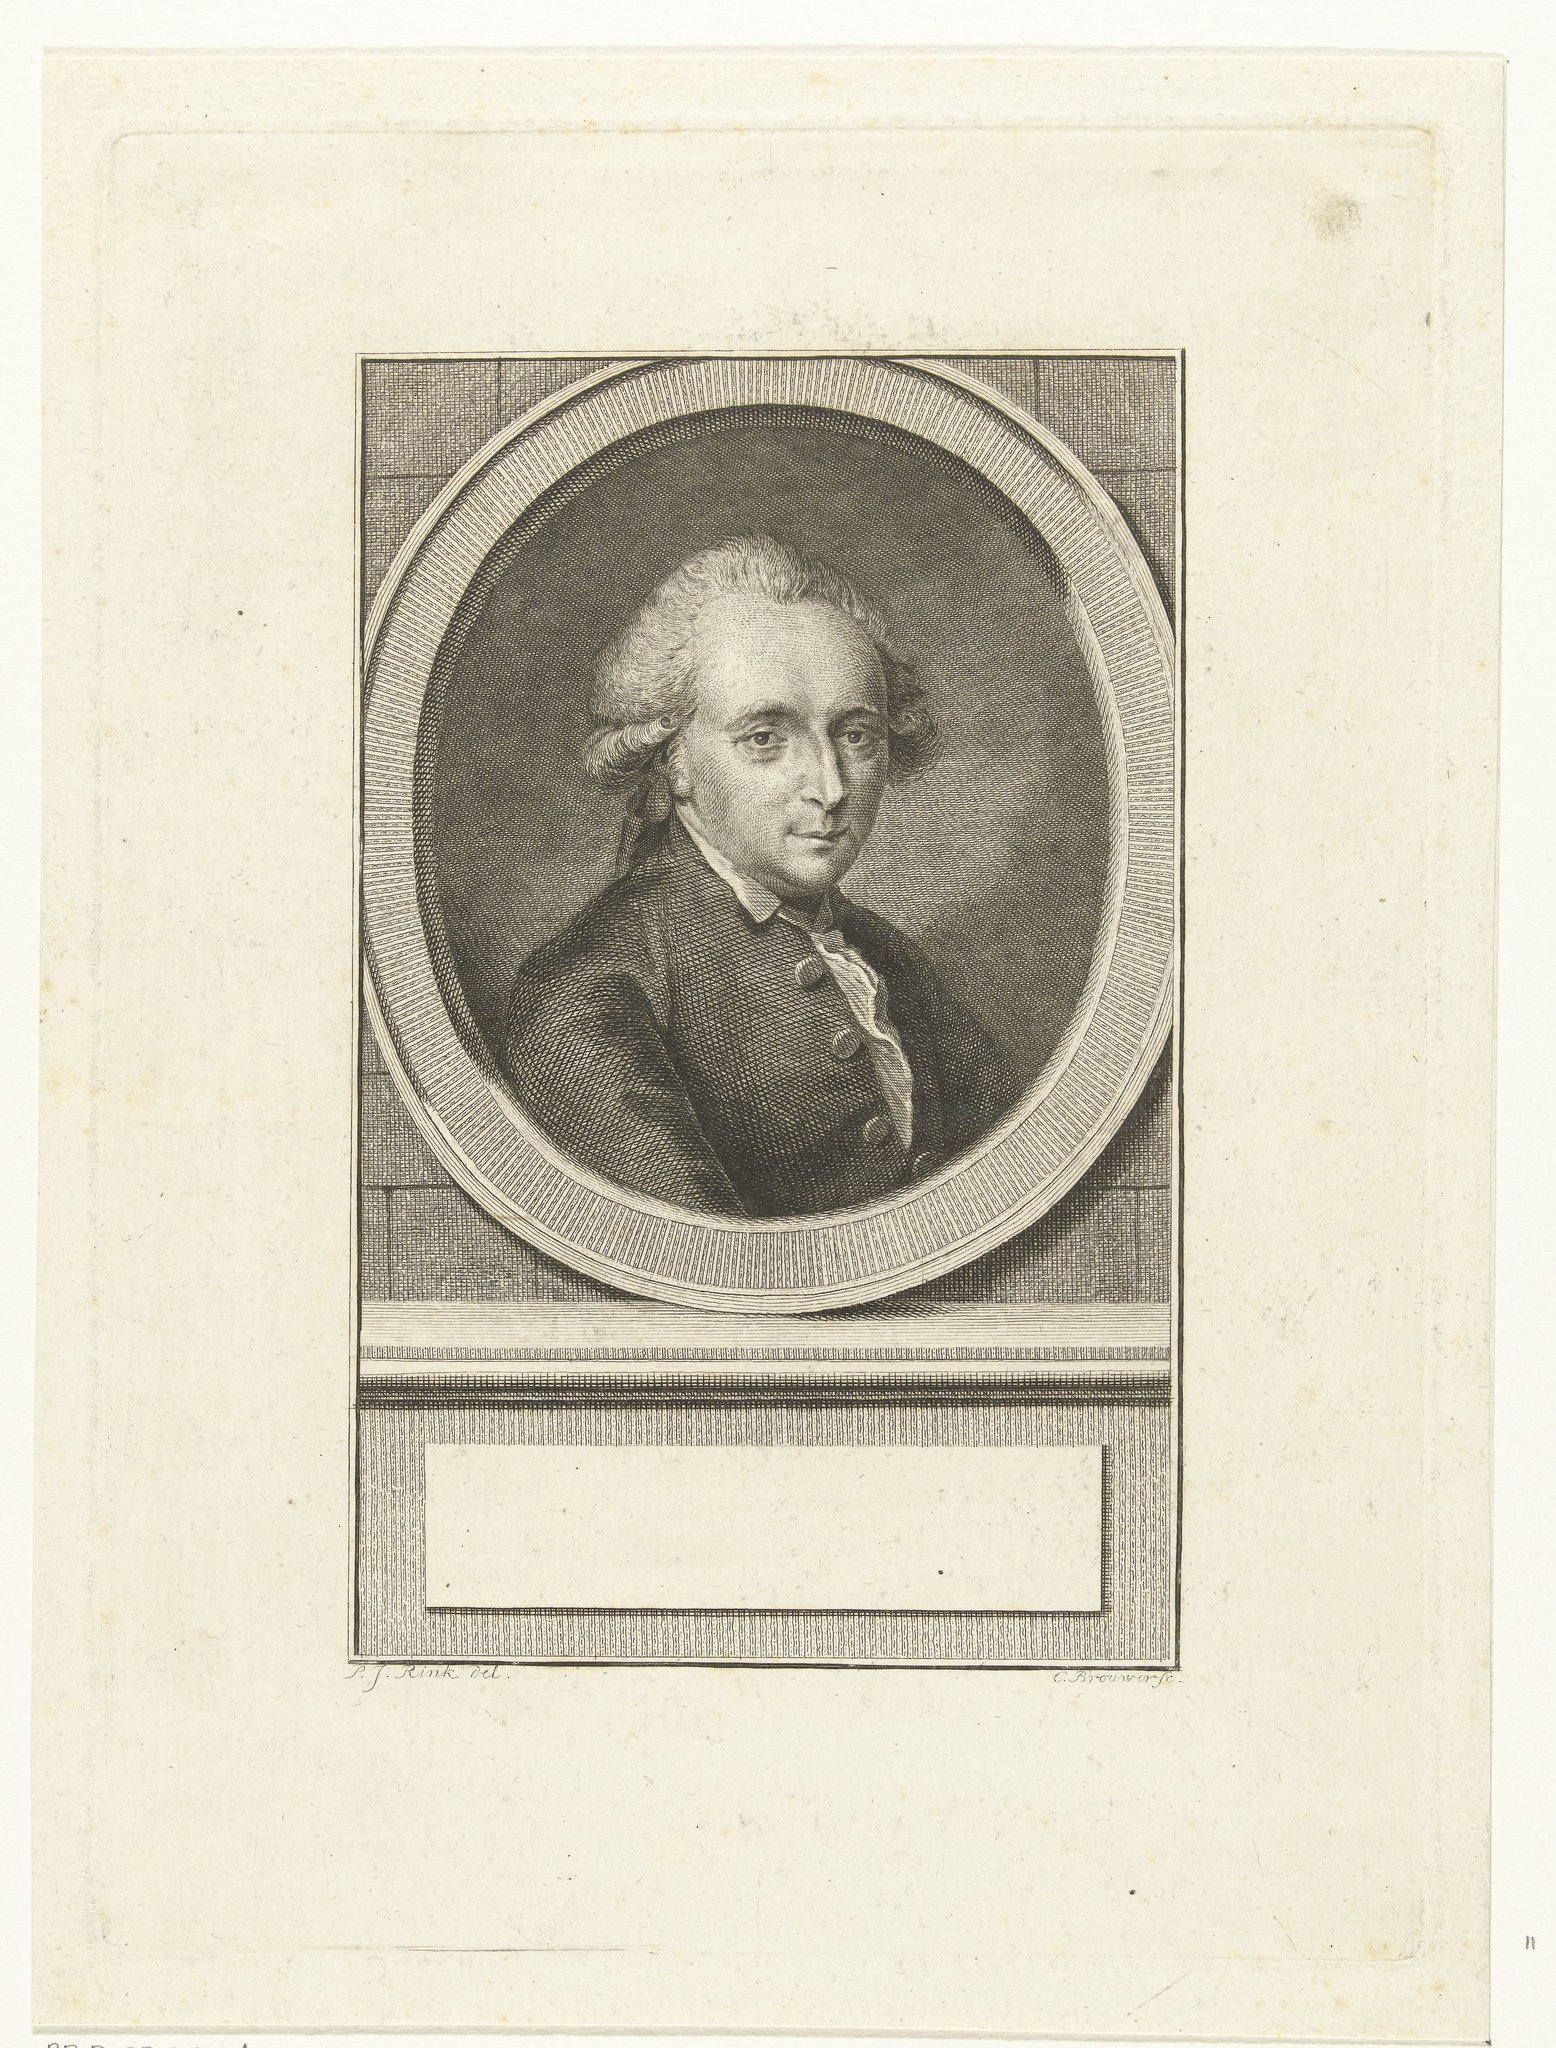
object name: print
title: Portret van Pieter Leonard van de Kasteele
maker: cornelis brouwer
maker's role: print maker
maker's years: 1731-1803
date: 1787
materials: paper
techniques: engraving, etching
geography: netherlands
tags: the hague, pieter leonard van de kasteele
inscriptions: collector's mark: Lugt 2228